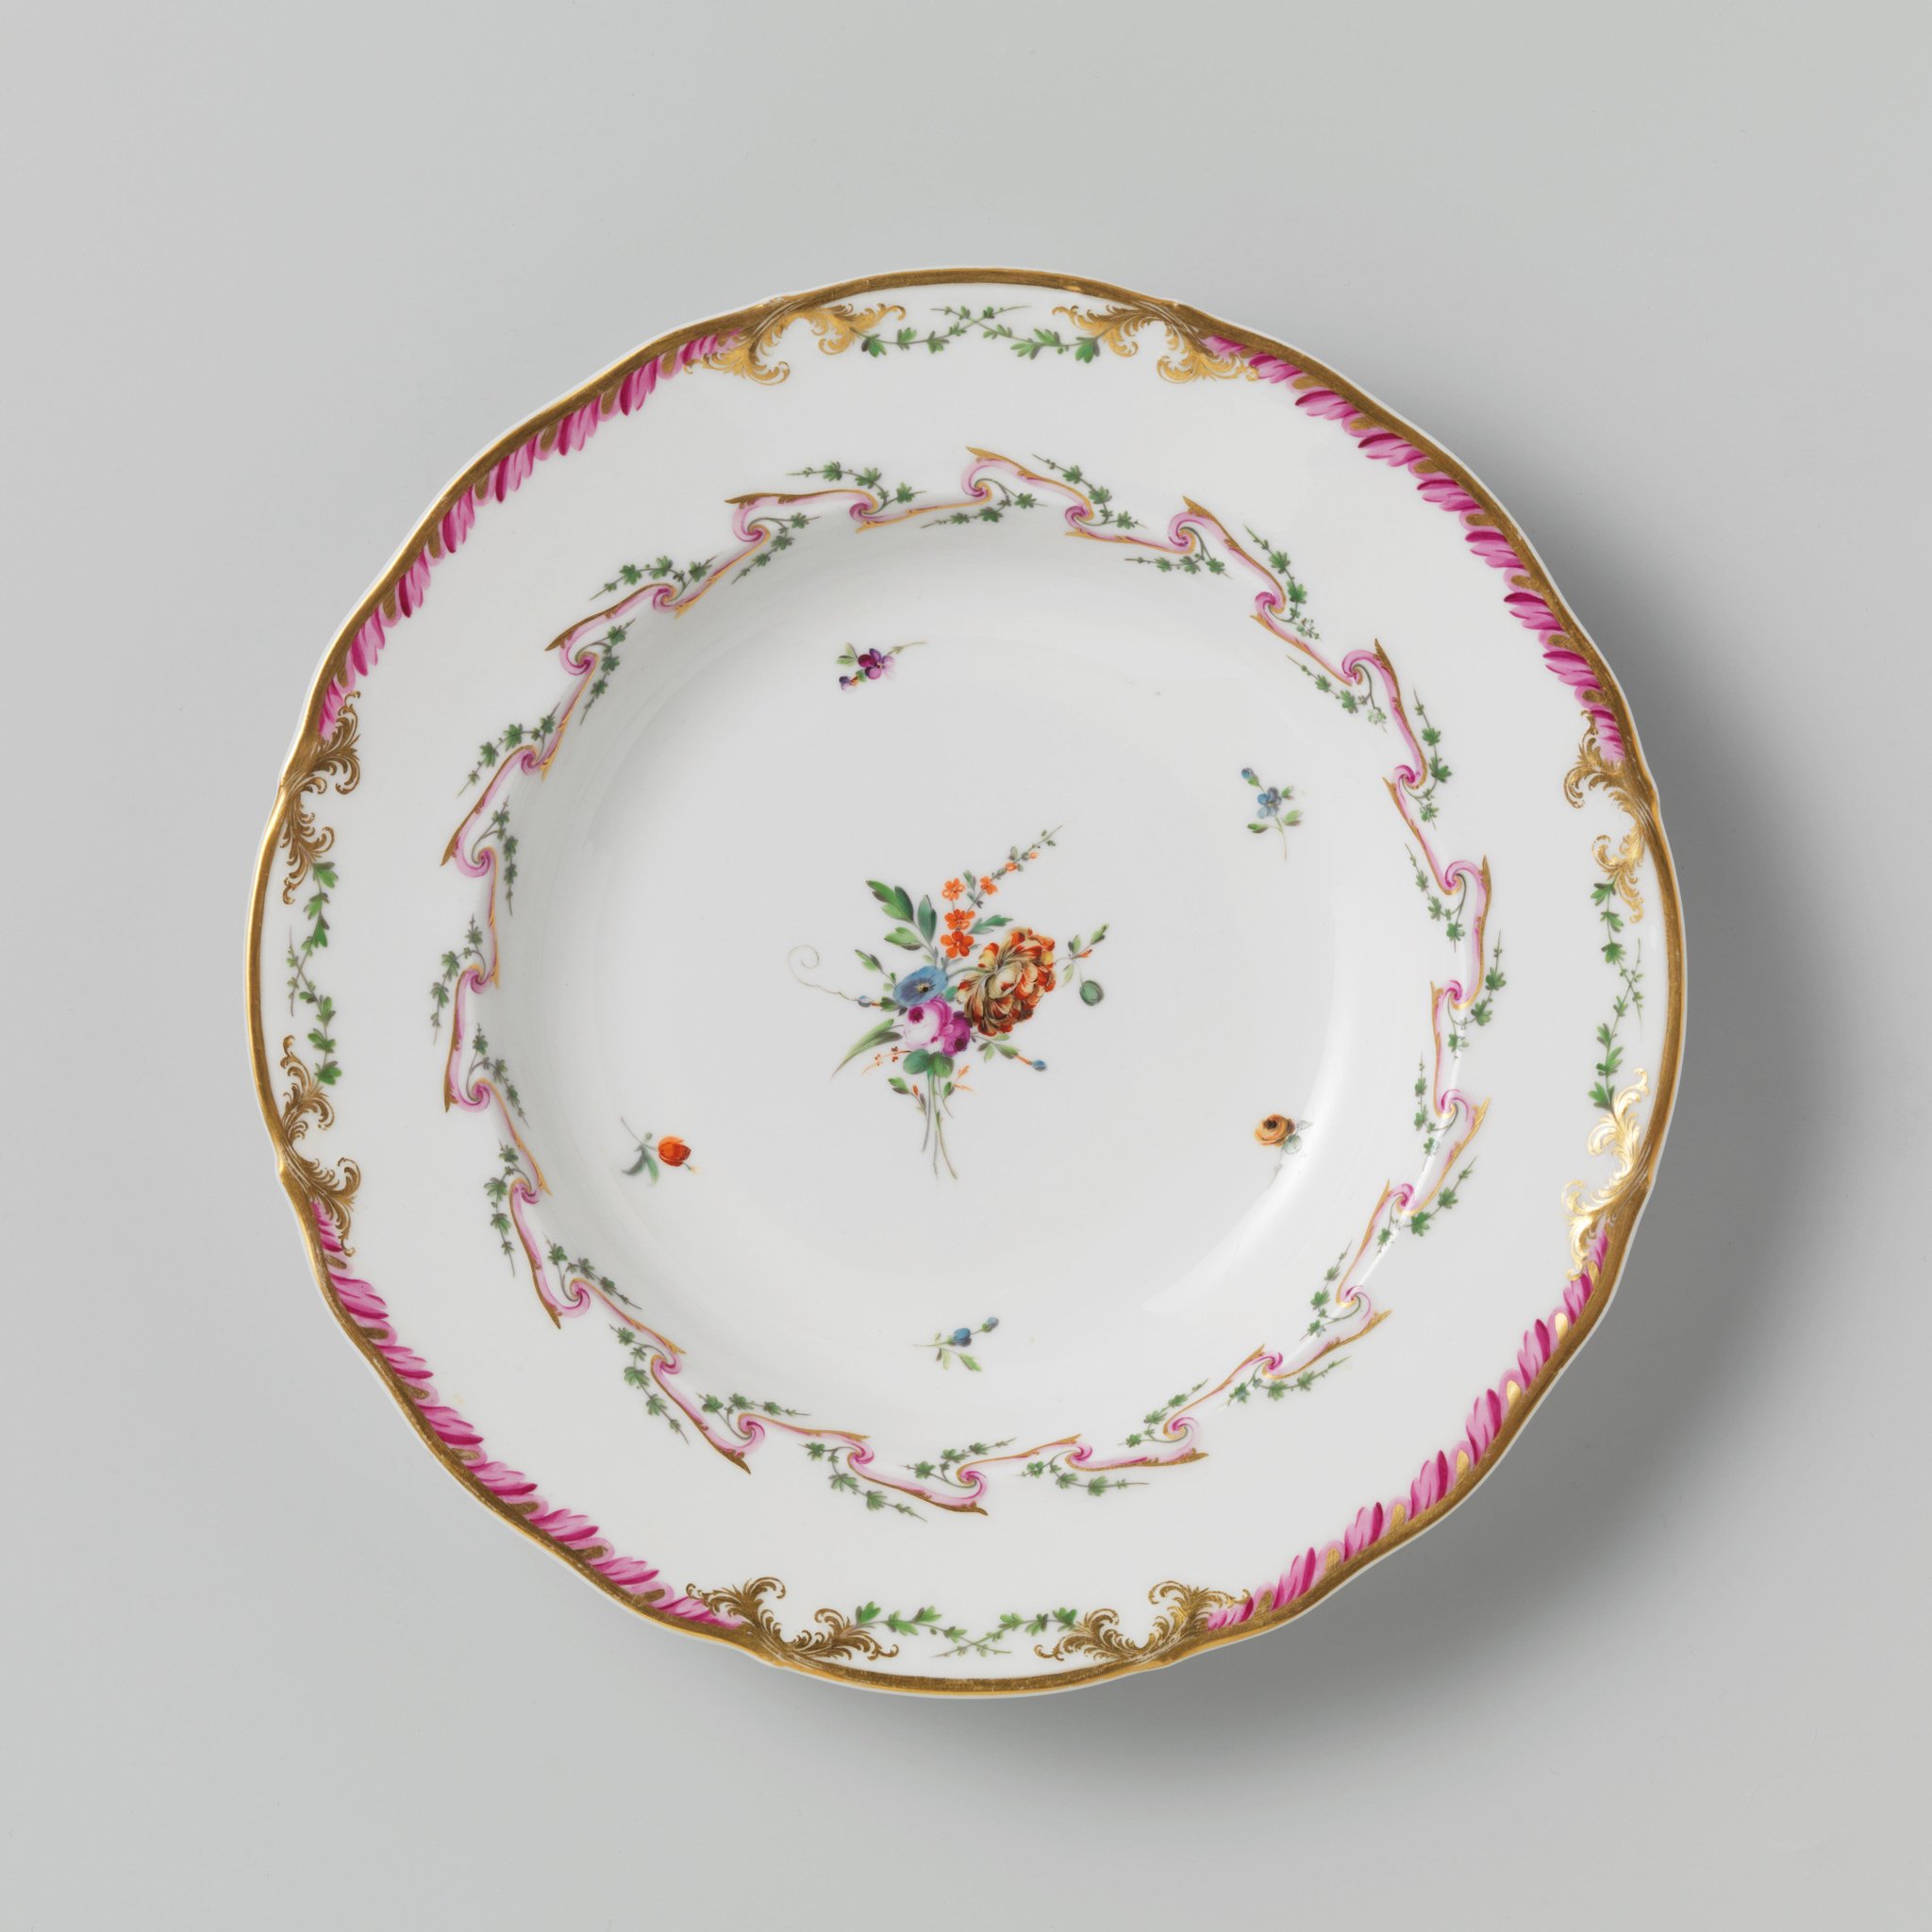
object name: plate dish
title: Bord, diep model, behorend bij een servies met geslingerd lintmotief met bladertakken, bloemboeketten en gestrooide bloemtakken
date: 1780-1820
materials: porcelain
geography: amsterdam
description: Bord, diep model, behorend bij een servies van porselein met geslingerd lintmotief in paars en goud met groene bladertakken, bloemboeketten en gestrooide bloemtakken. Randen lichtgegolfd met decoratie in goud met paars bladmotief waartussen groen gekruist bladmotief. Gemerkt: Mf. DE DIHL ET GUERHARD à PARIS. Serie van elf stuks.